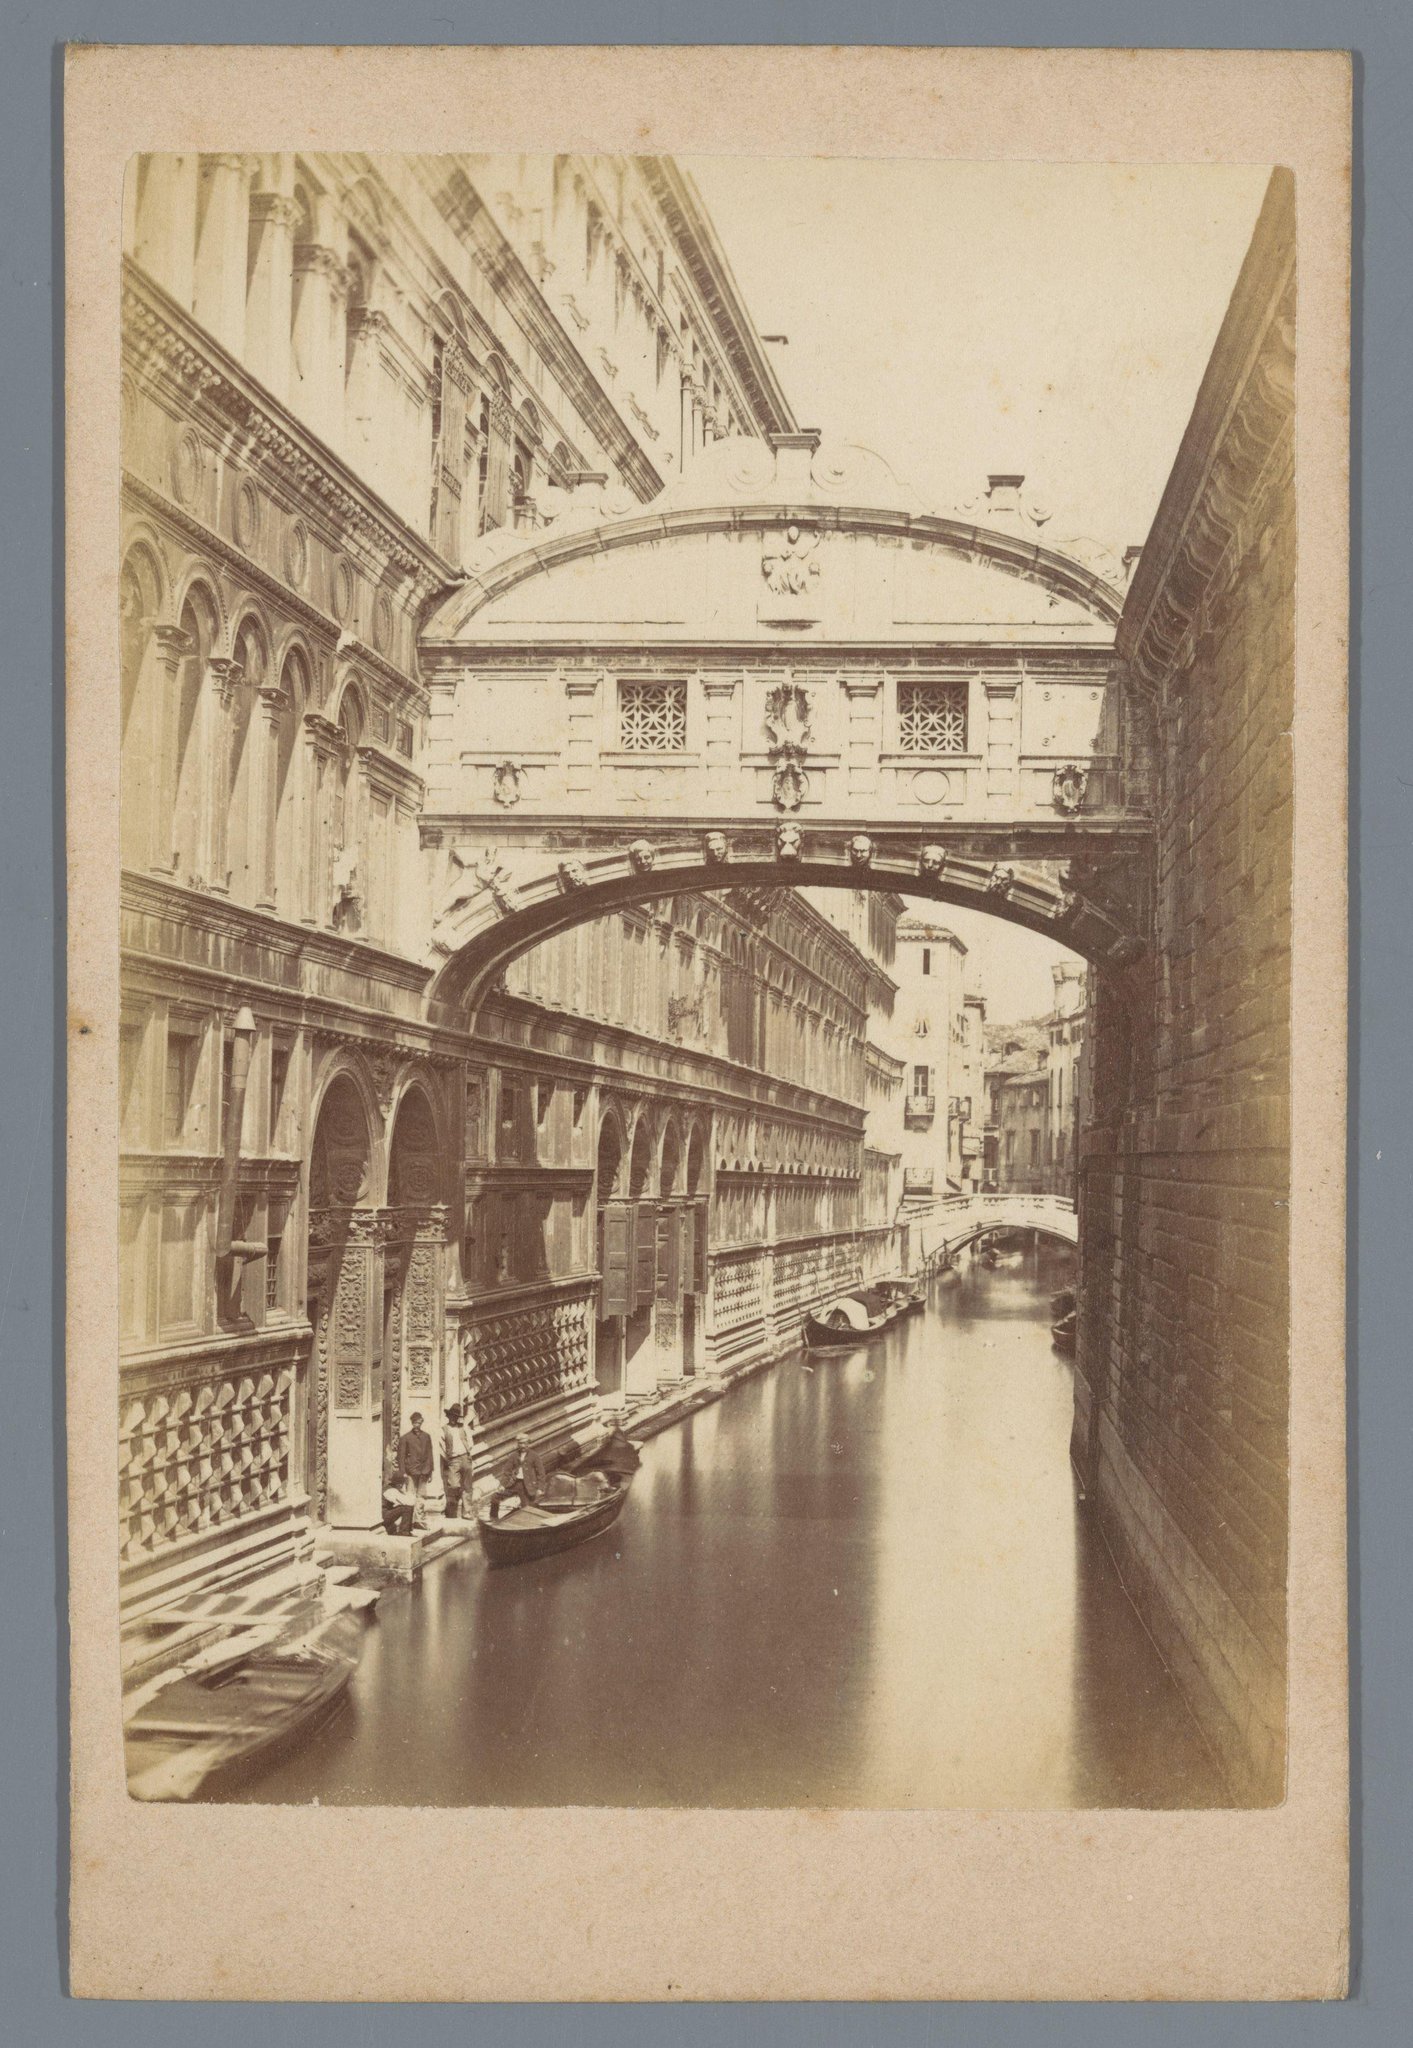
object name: cabinet photograph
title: Gezicht op de Ponte dei Sospiri in Venetië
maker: Anonymous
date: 1850-1900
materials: cardboard, photographic support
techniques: albumen print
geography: ponte dei sospiri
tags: canals, waters (in city), bridge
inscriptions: annotation: ‘Venezia ponte dei Sospiri’